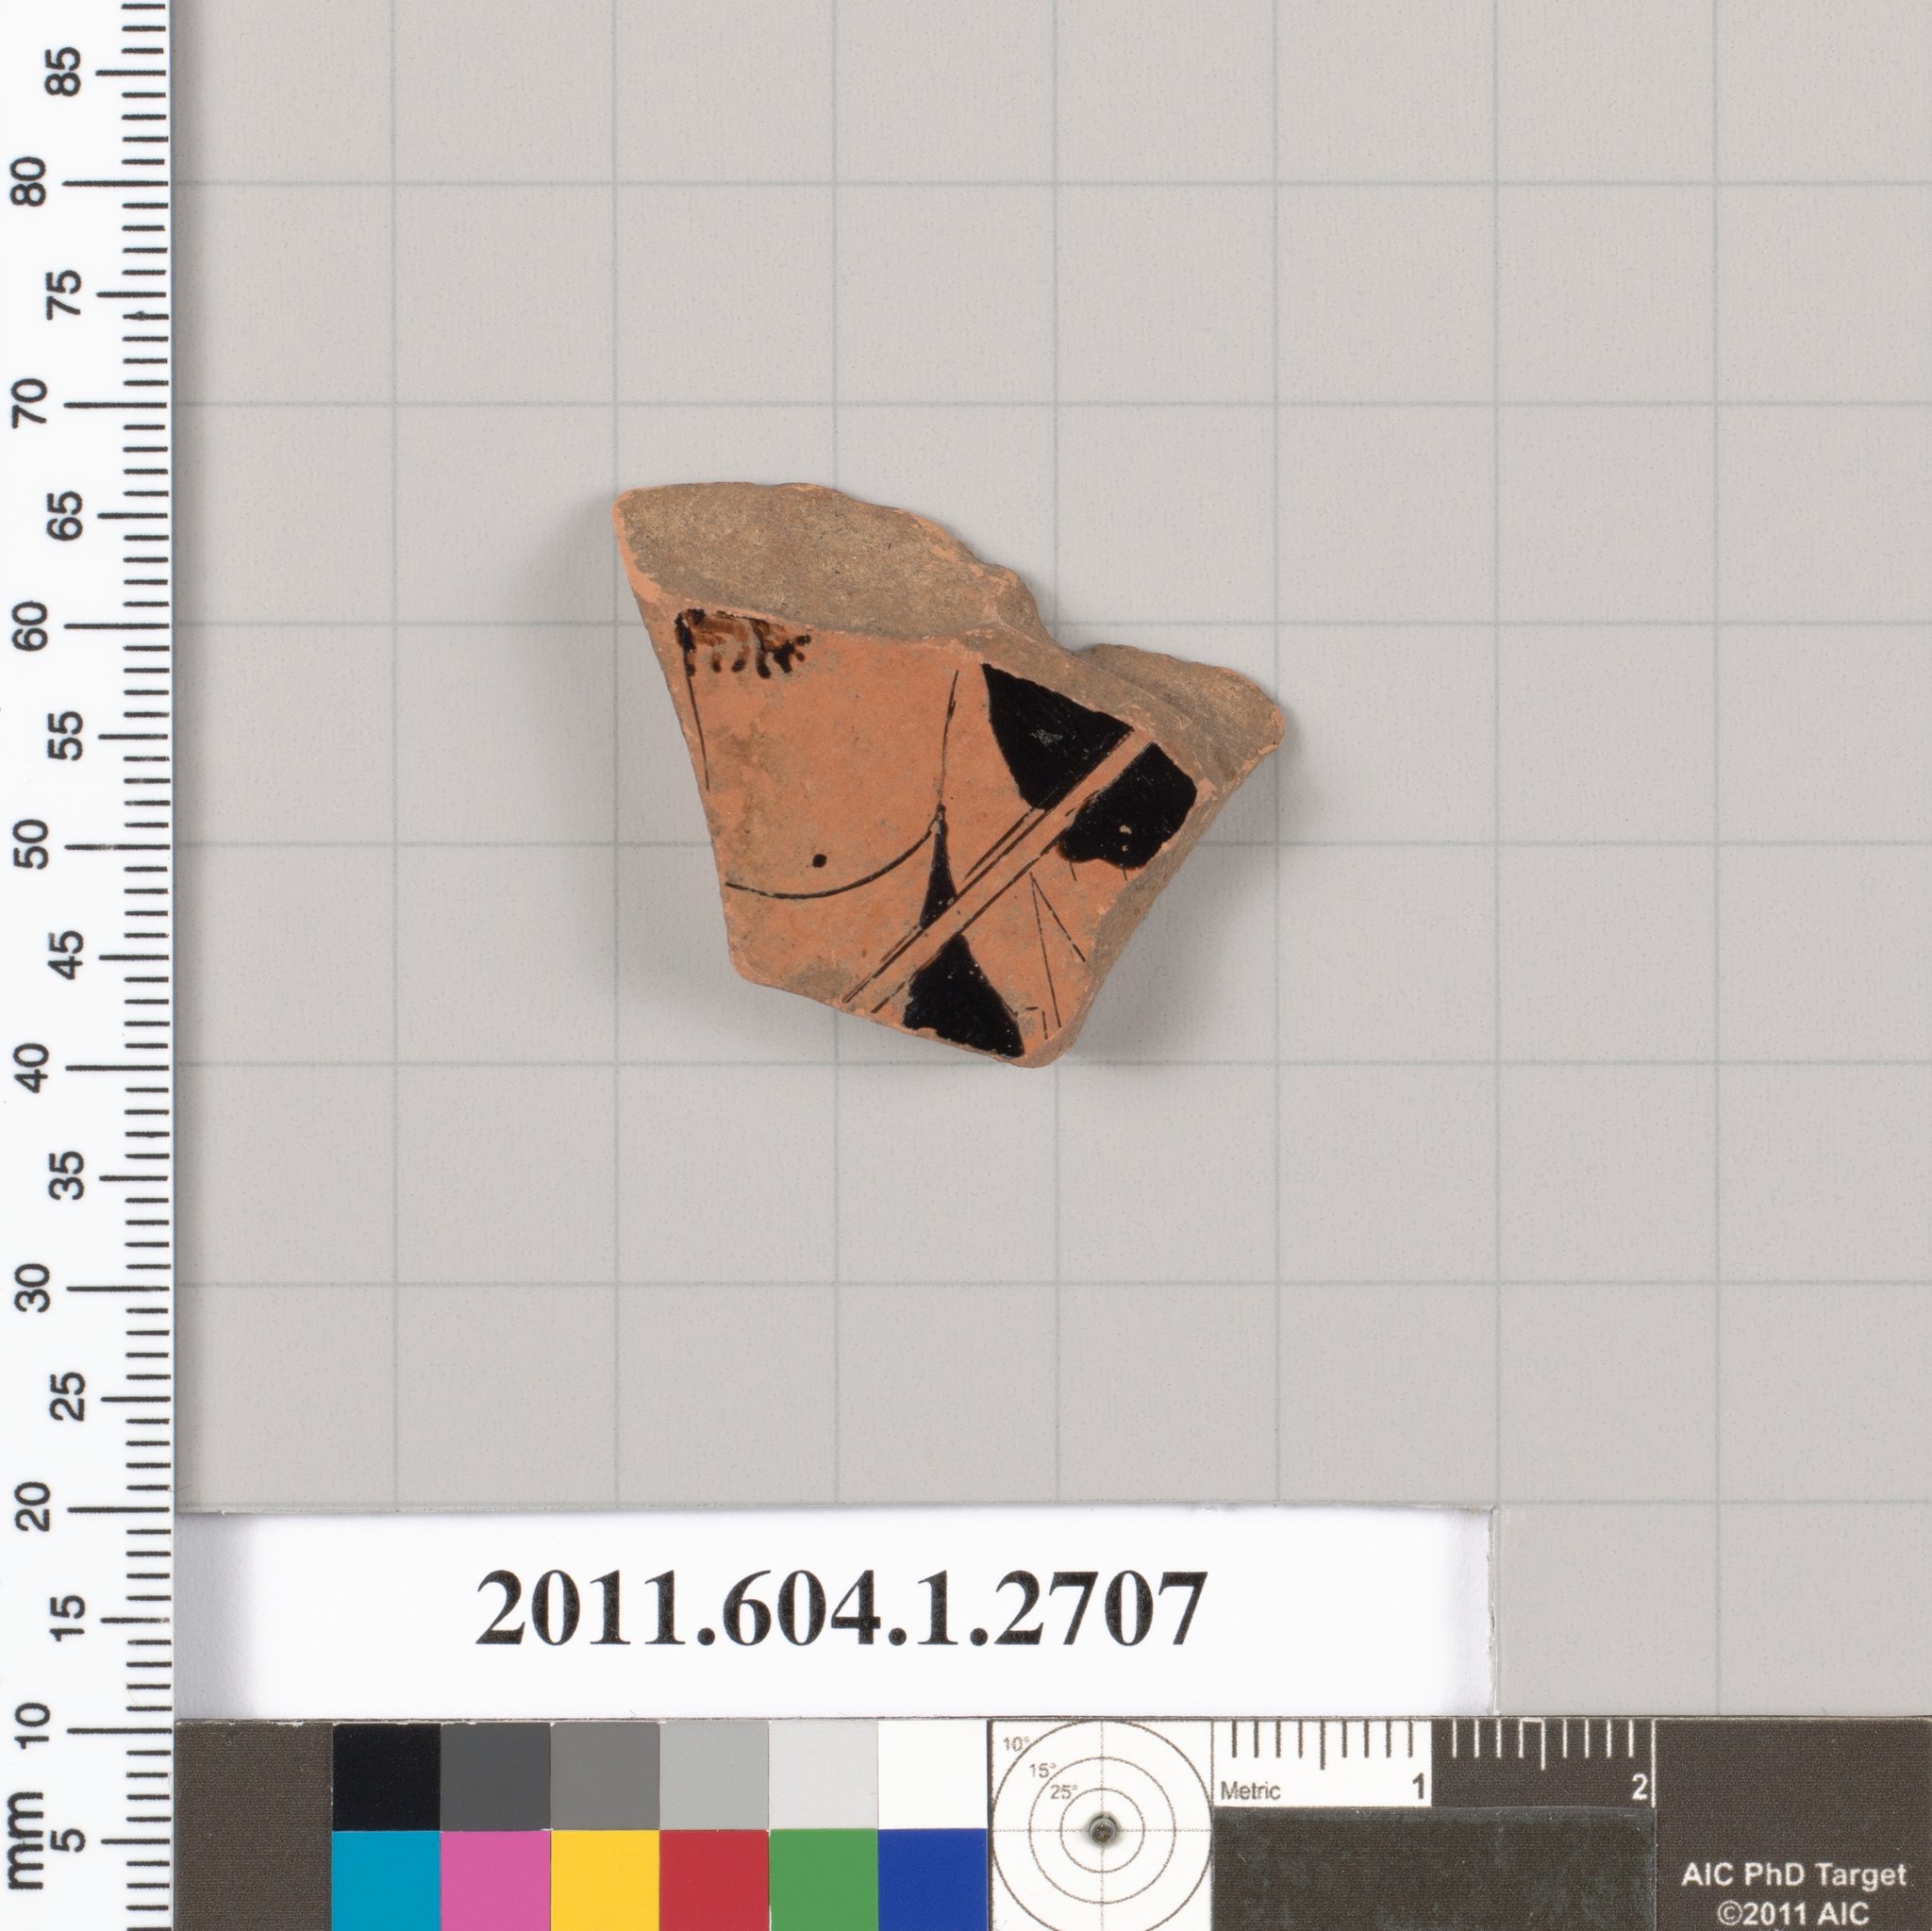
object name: kylix fragment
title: Terracotta fragment of a kylix (drinking cup)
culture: greek, attic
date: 470-460 BCE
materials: terracotta